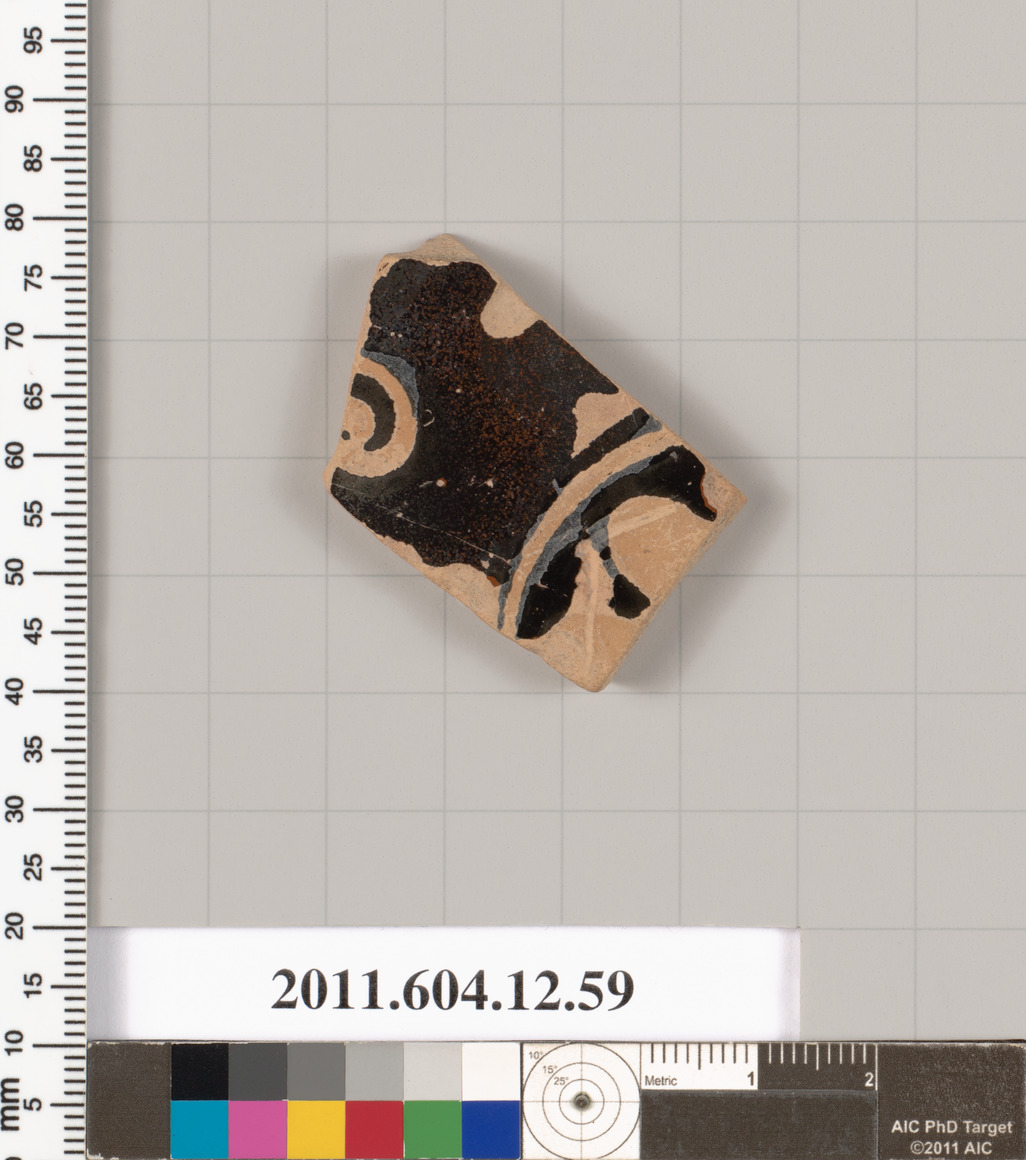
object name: undetermined open shape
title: Terracotta fragment of an open shape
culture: greek or south italian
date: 400-301 BCE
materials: terracotta